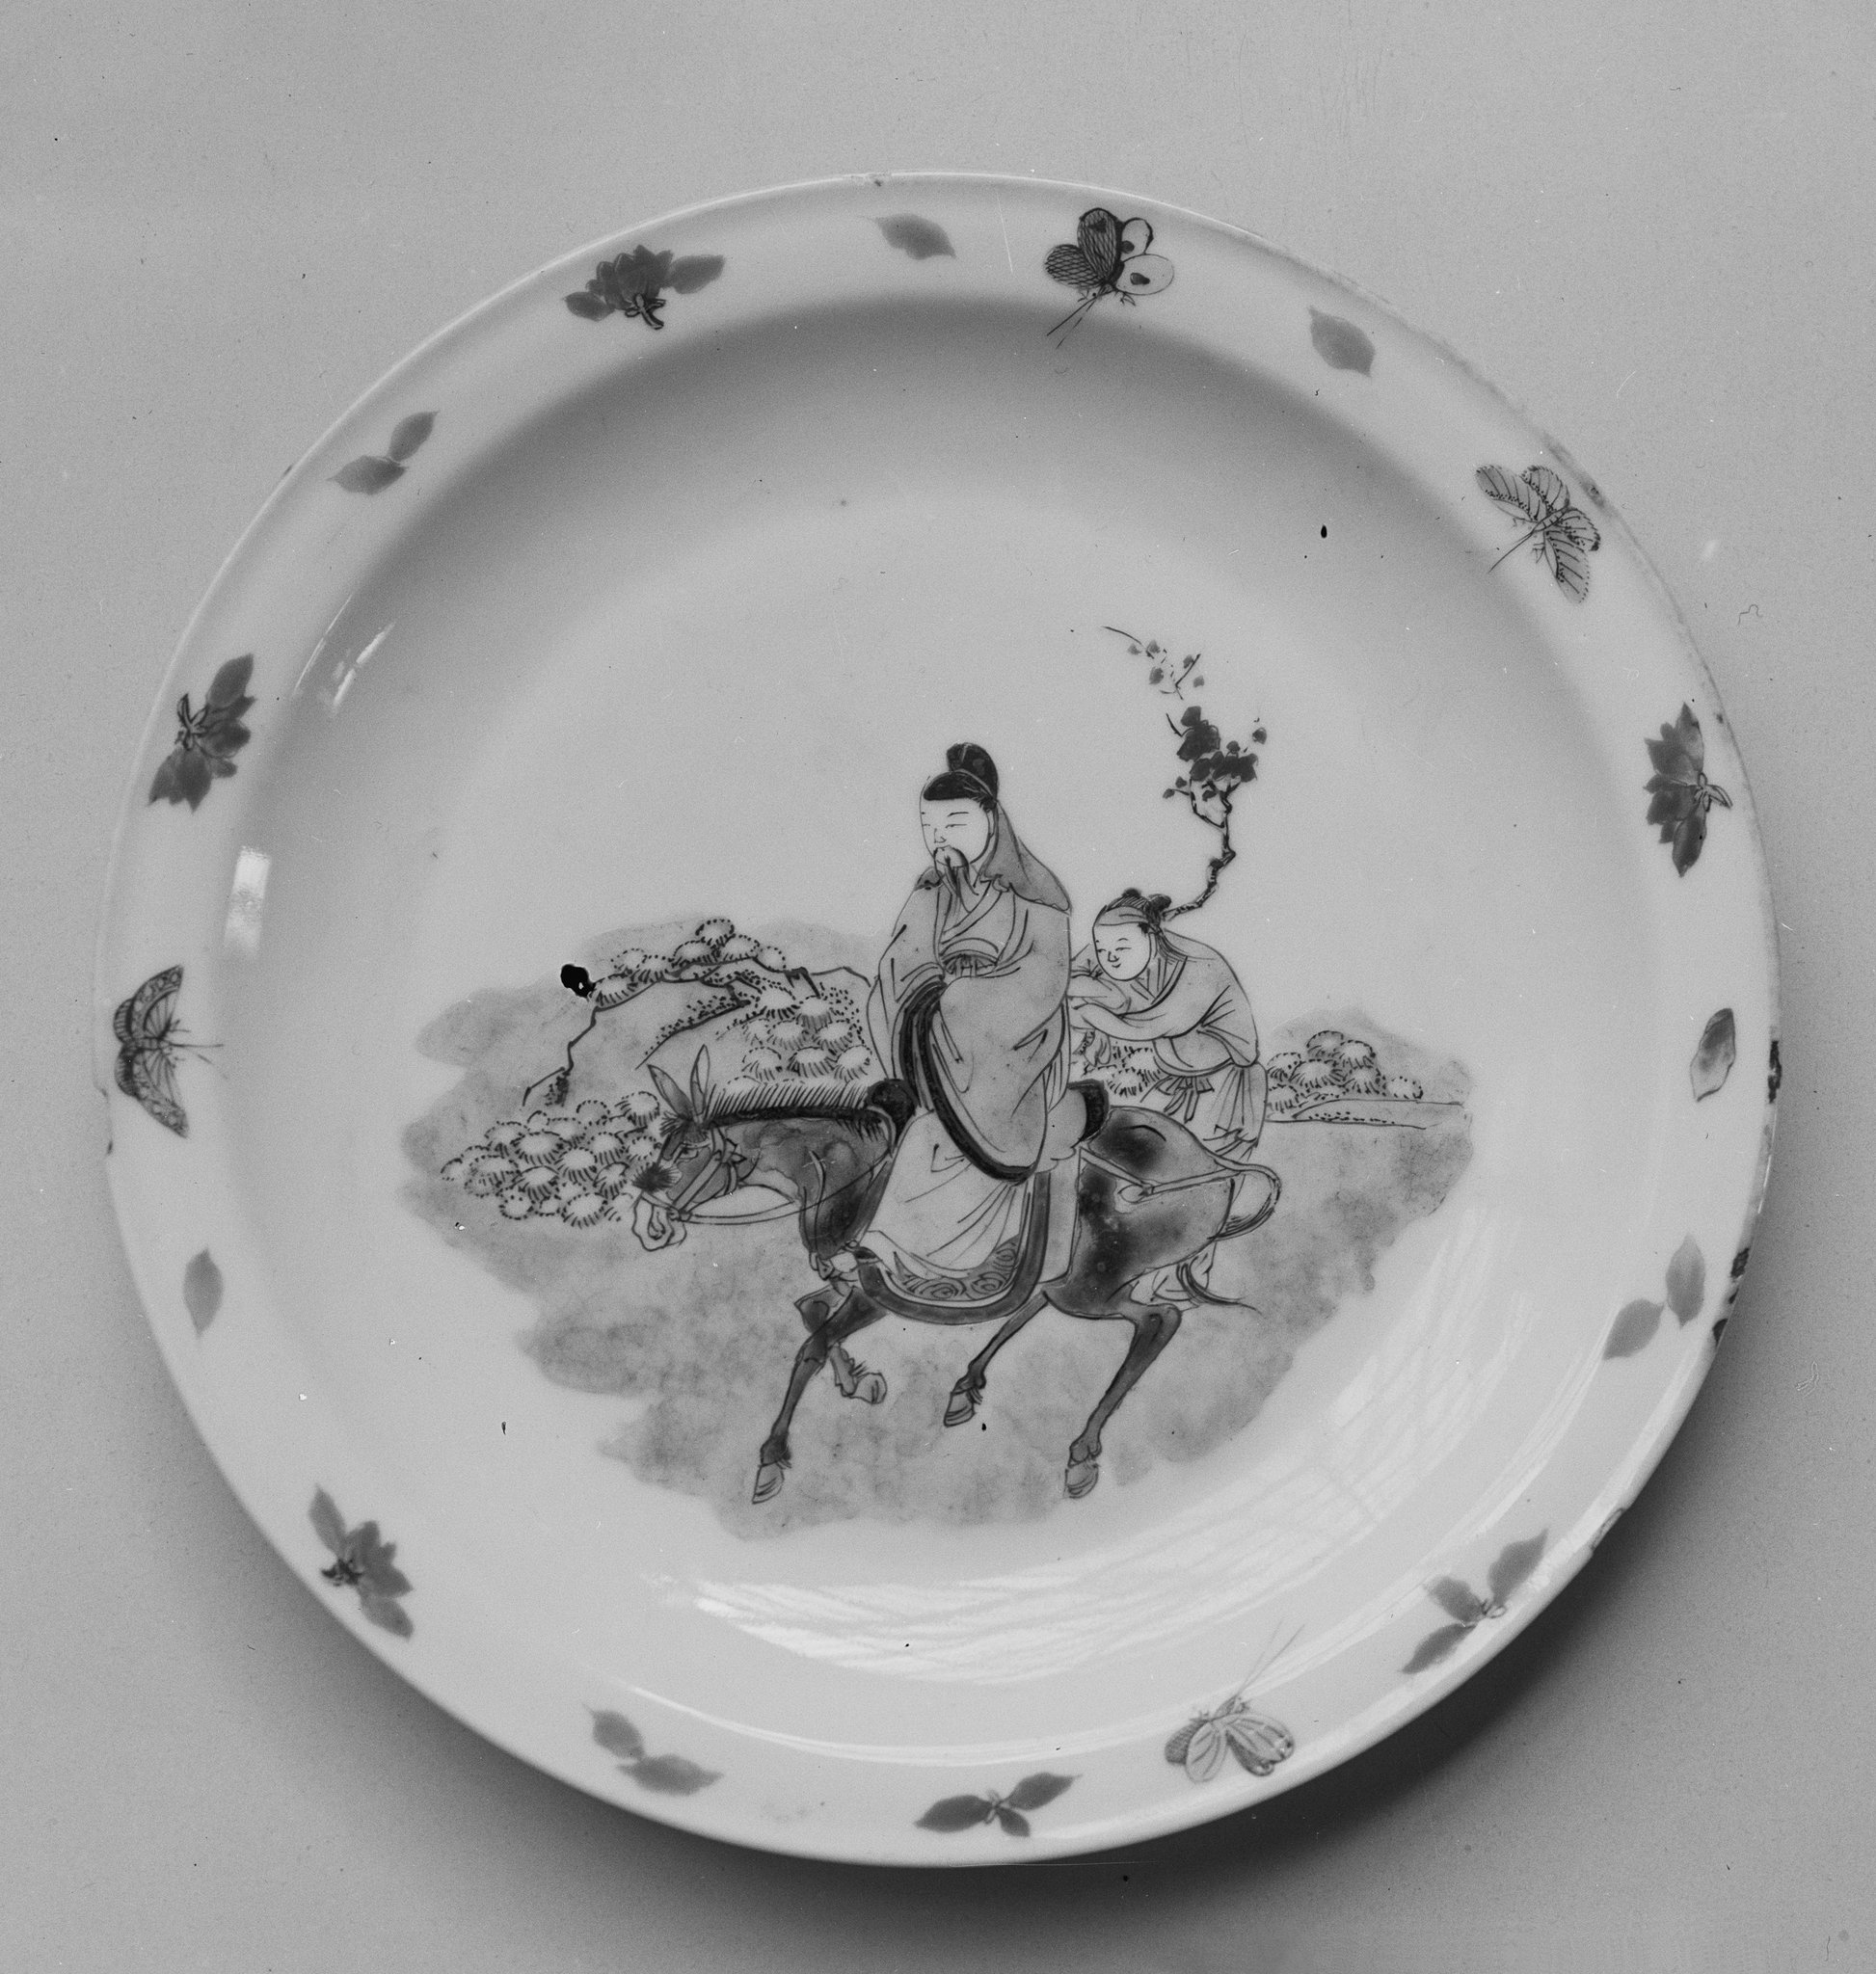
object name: plate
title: Plate with scholar and plum branches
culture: chinese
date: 1701-1733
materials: enamel, gold, porcelain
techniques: overglaze, painting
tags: horses